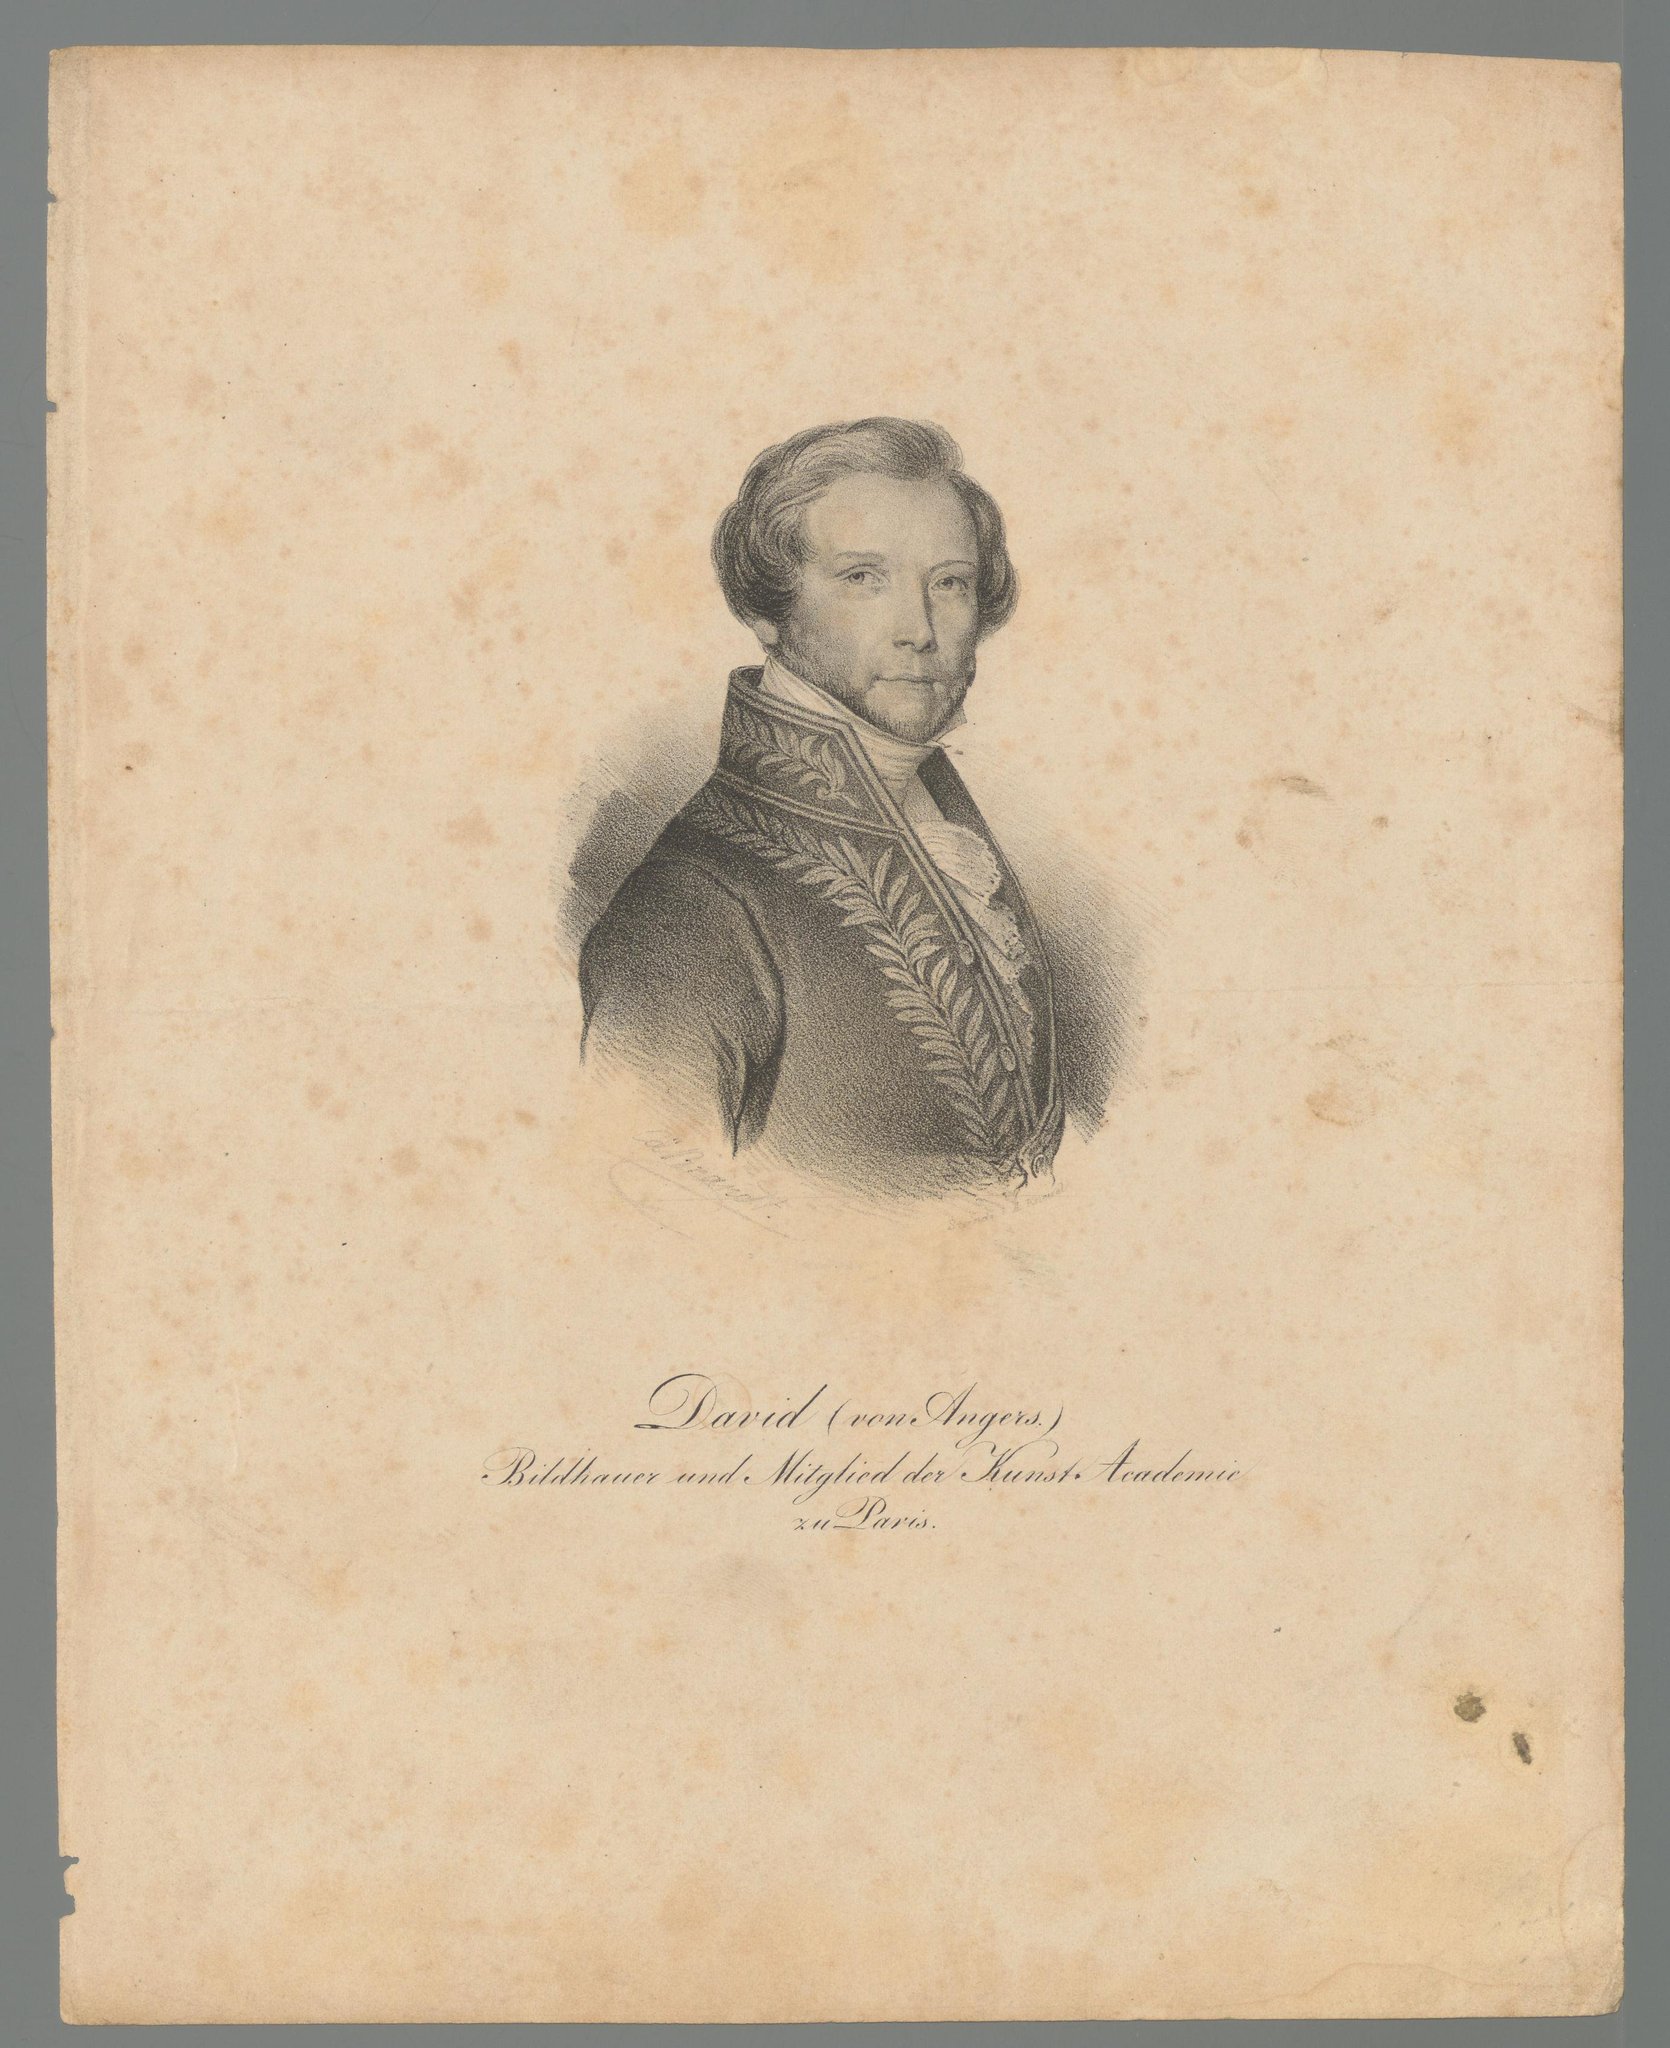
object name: print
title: Portret van Pierre Jean David d'Angers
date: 1830-1850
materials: paper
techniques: lithograph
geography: leipzig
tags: paris, sculptor, pierre jean david d'angers, adult man, historical persons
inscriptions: collector's mark: Lugt 2760, collector's mark: Lugt 2228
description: David von Angers (1788-1856), beeldhouwer en lid van de Academie des Beaux Arts in Parijs. Buste naar rechts.